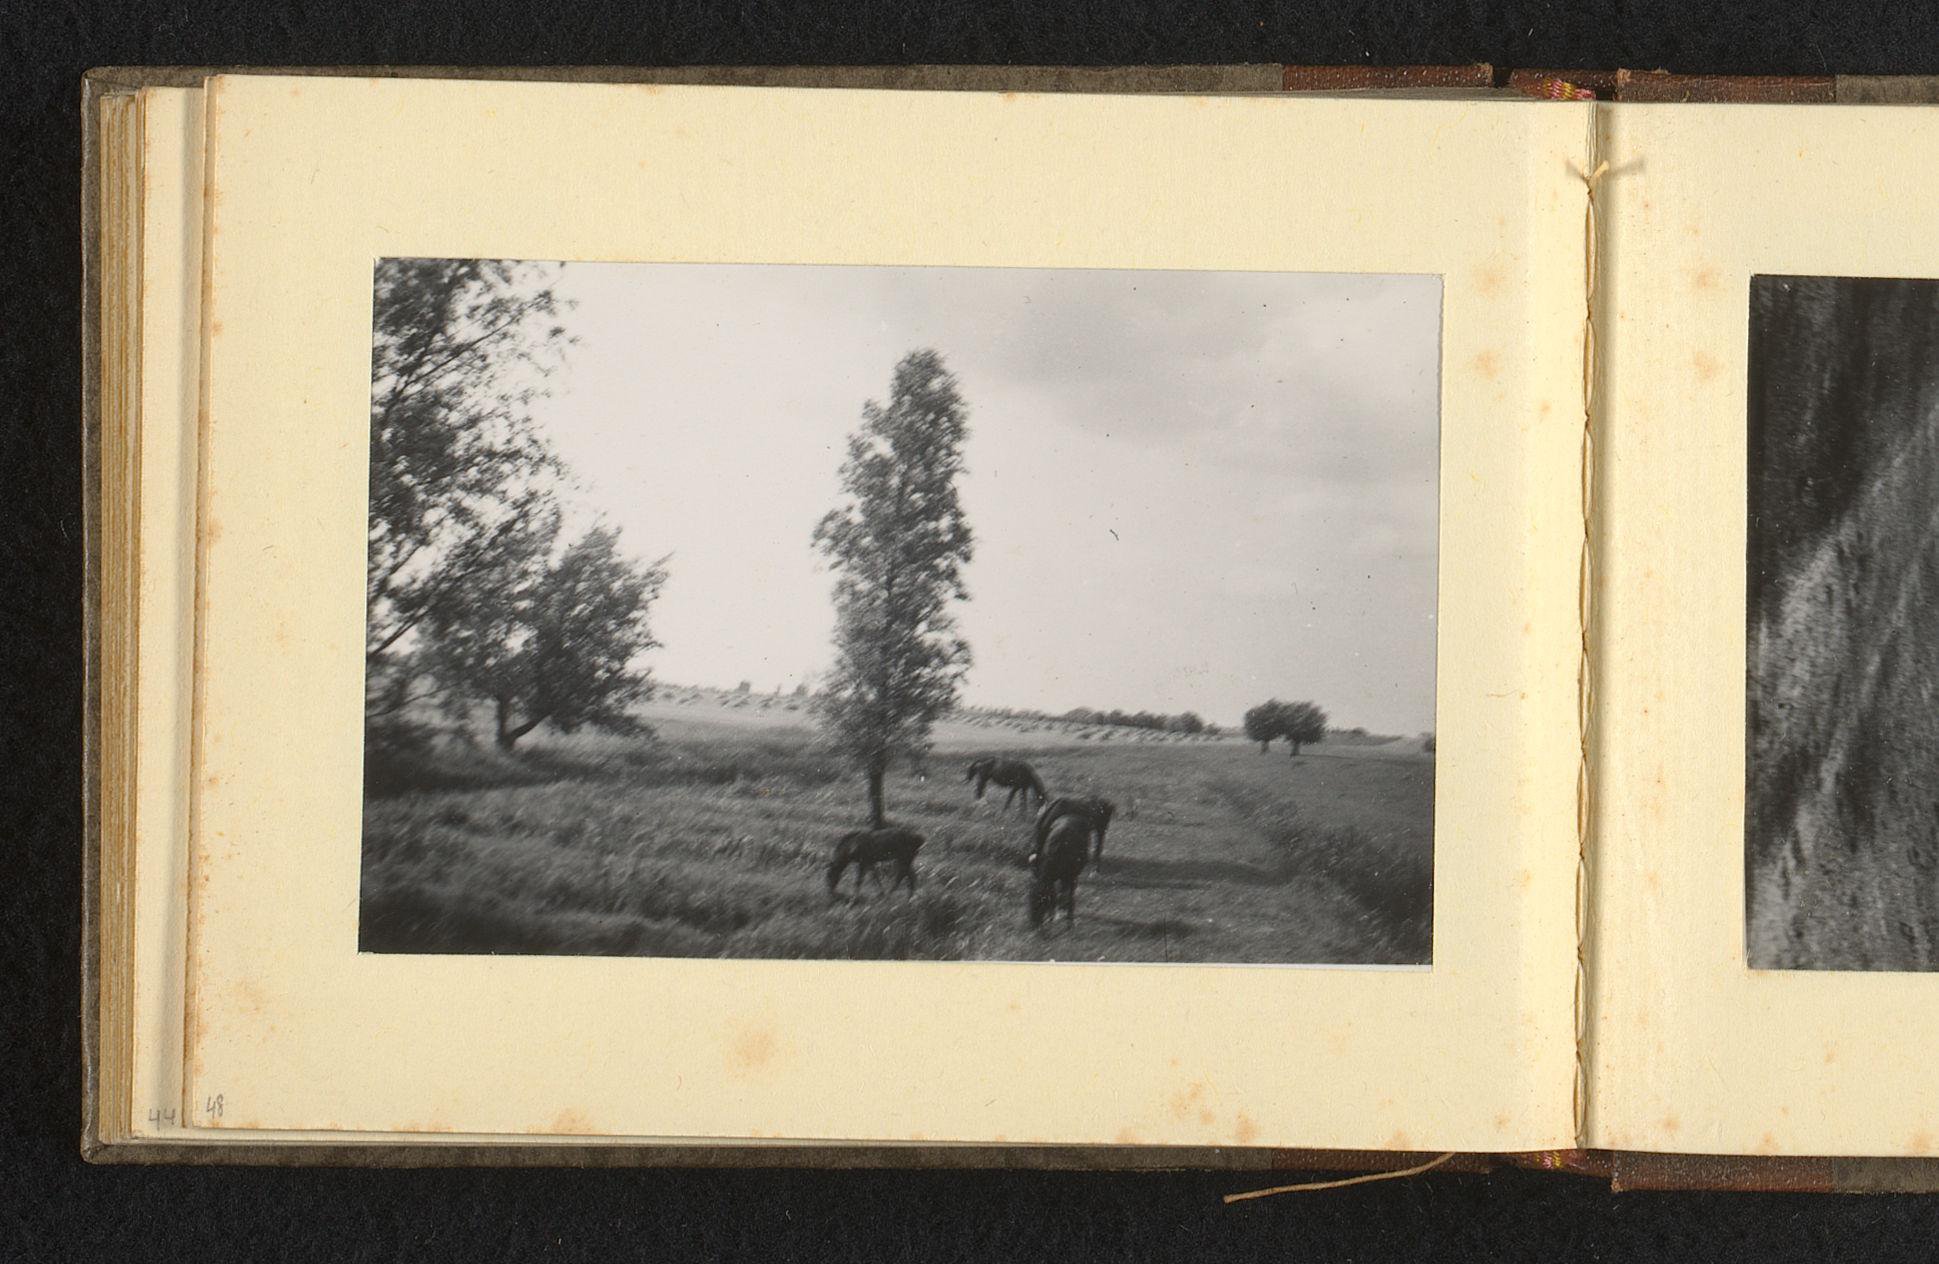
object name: photograph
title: Weiland met paarden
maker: norbert van den berg (1901-1972)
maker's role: amateurfotograaf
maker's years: 1901-1972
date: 1935-1950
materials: paper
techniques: gelatin silver print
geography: netherlands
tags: meadow, pasture, horse